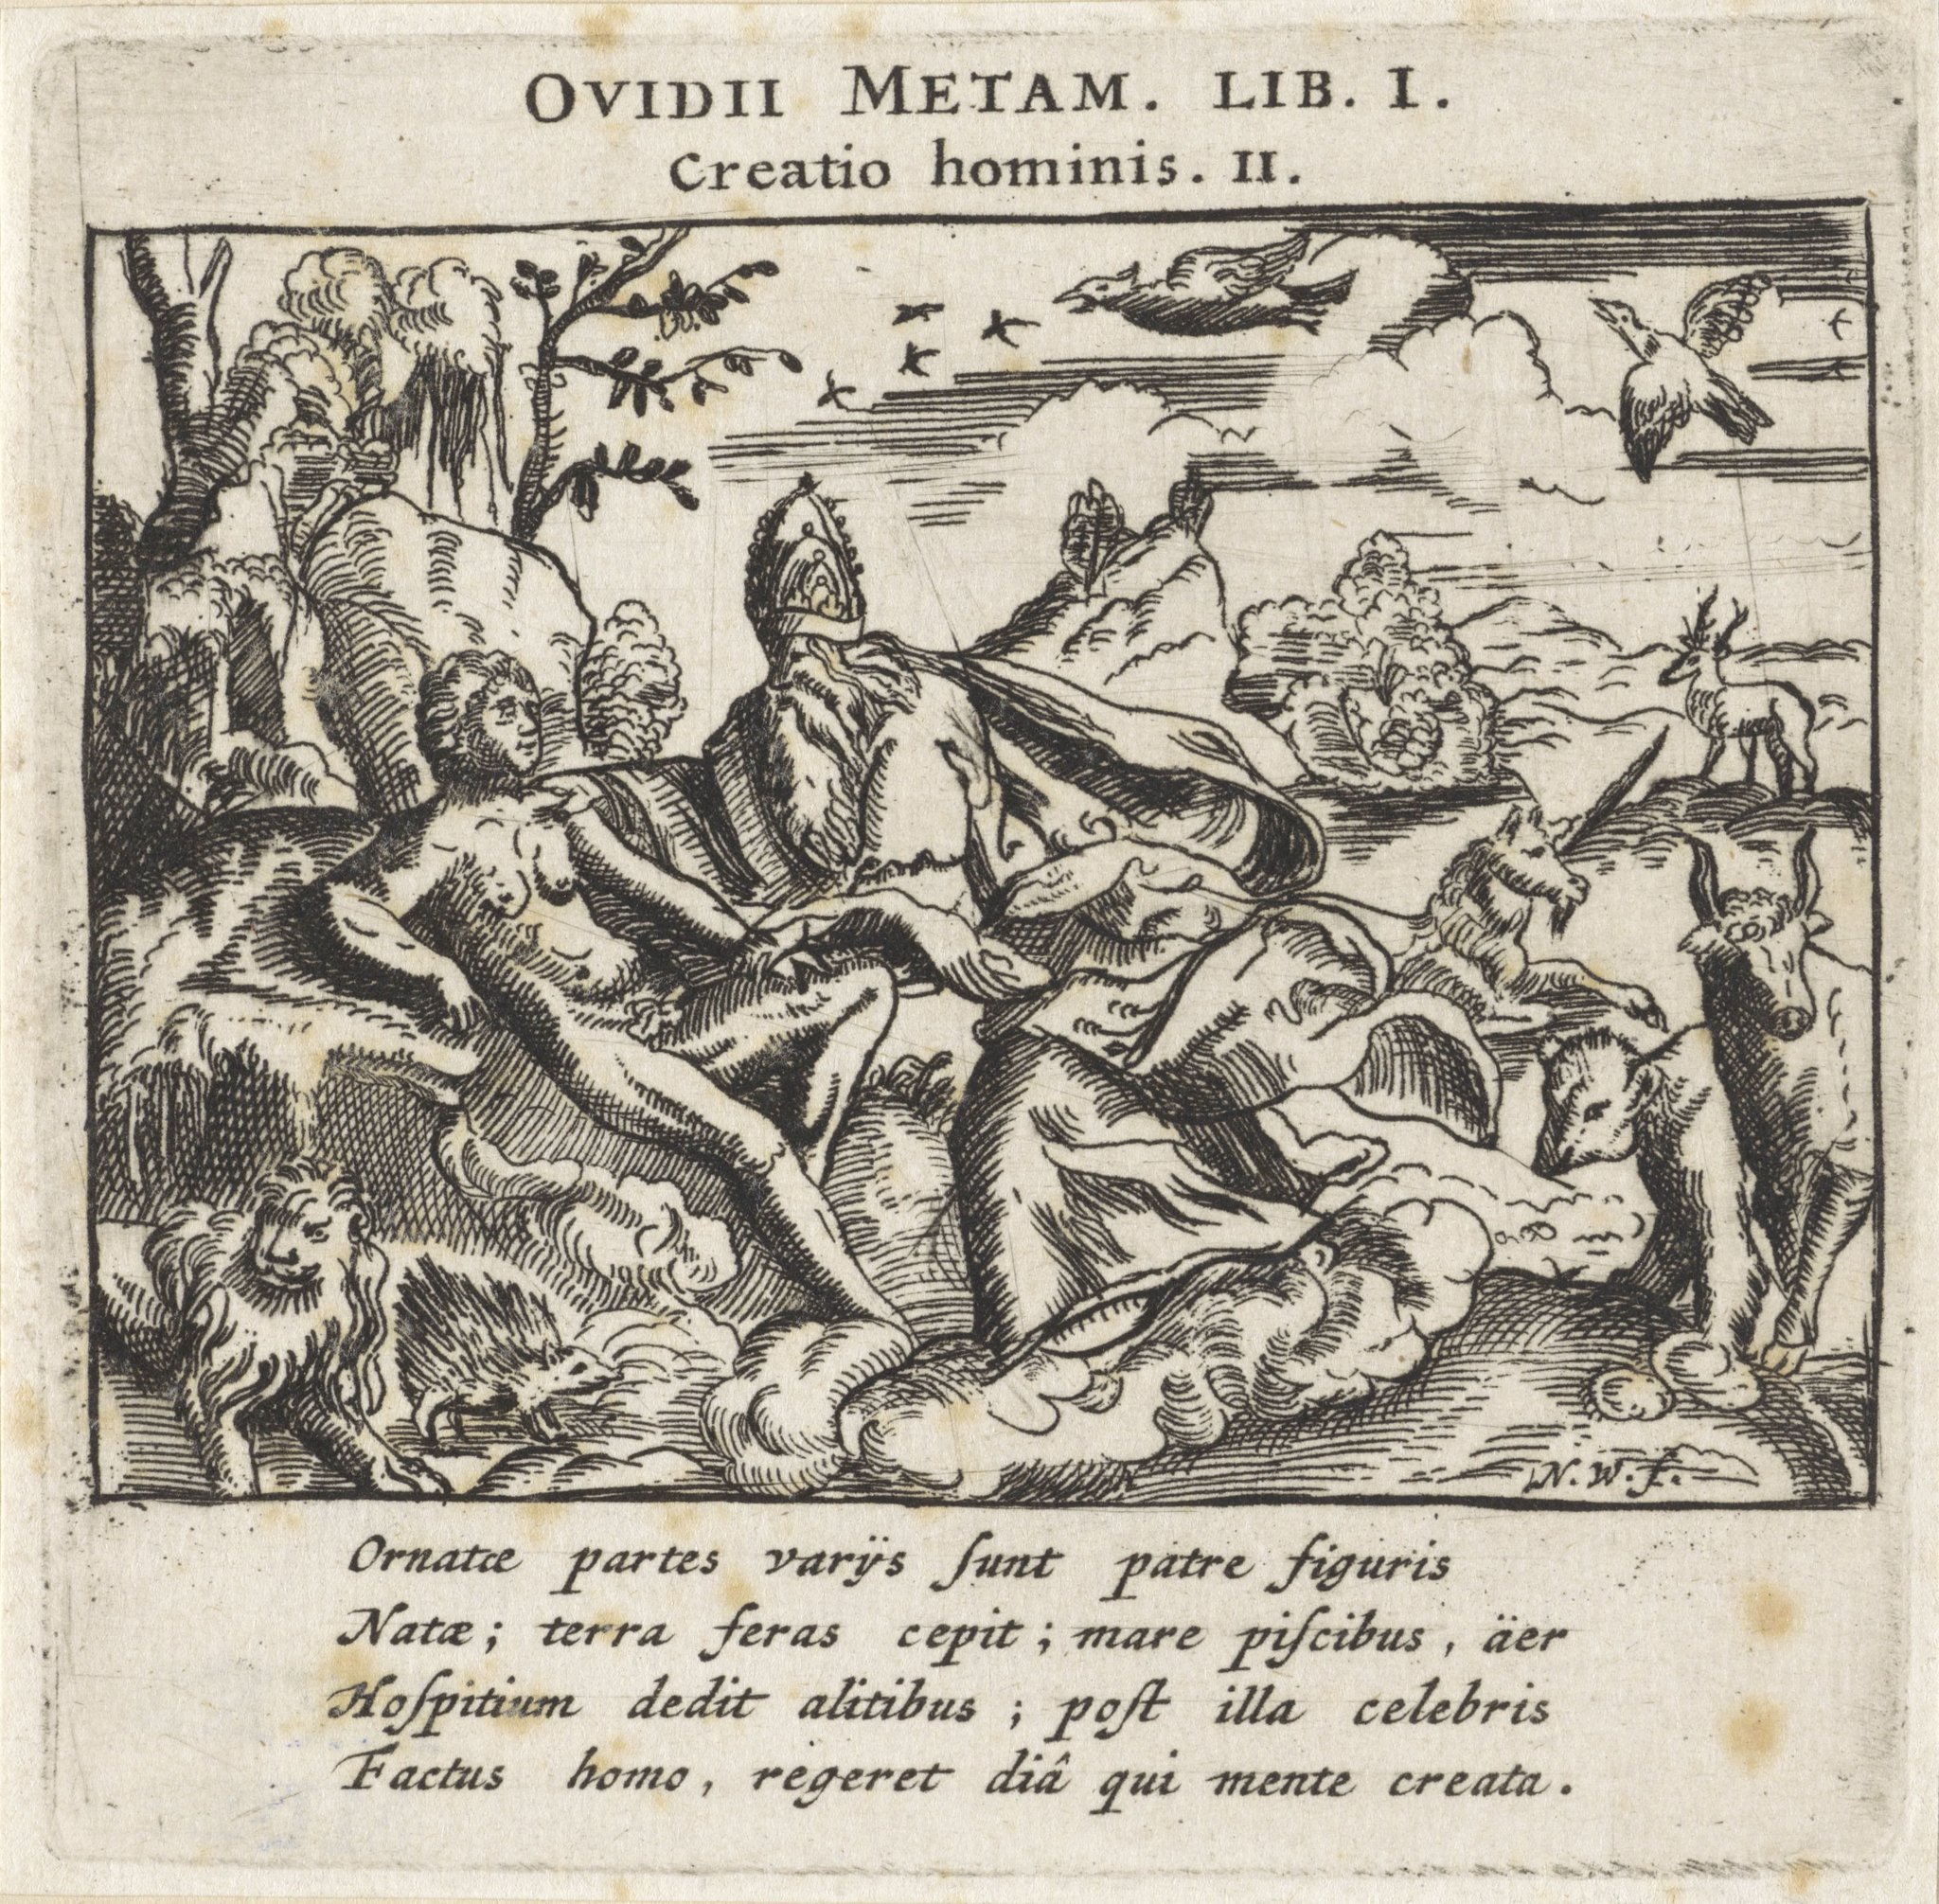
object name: print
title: Schepping van de mens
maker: nicolaes cornelisz. witsen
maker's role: mayor, print maker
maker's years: 1641-1717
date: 1659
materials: paper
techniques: etching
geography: amsterdam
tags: creation of man by some creative force, groups of animals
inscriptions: collector's mark: Lugt 2165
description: God schept de eerste man. Ze worden door verschillende dieren omringd. Onder de voorstelling een vierreglige toelichting in het Latijn.